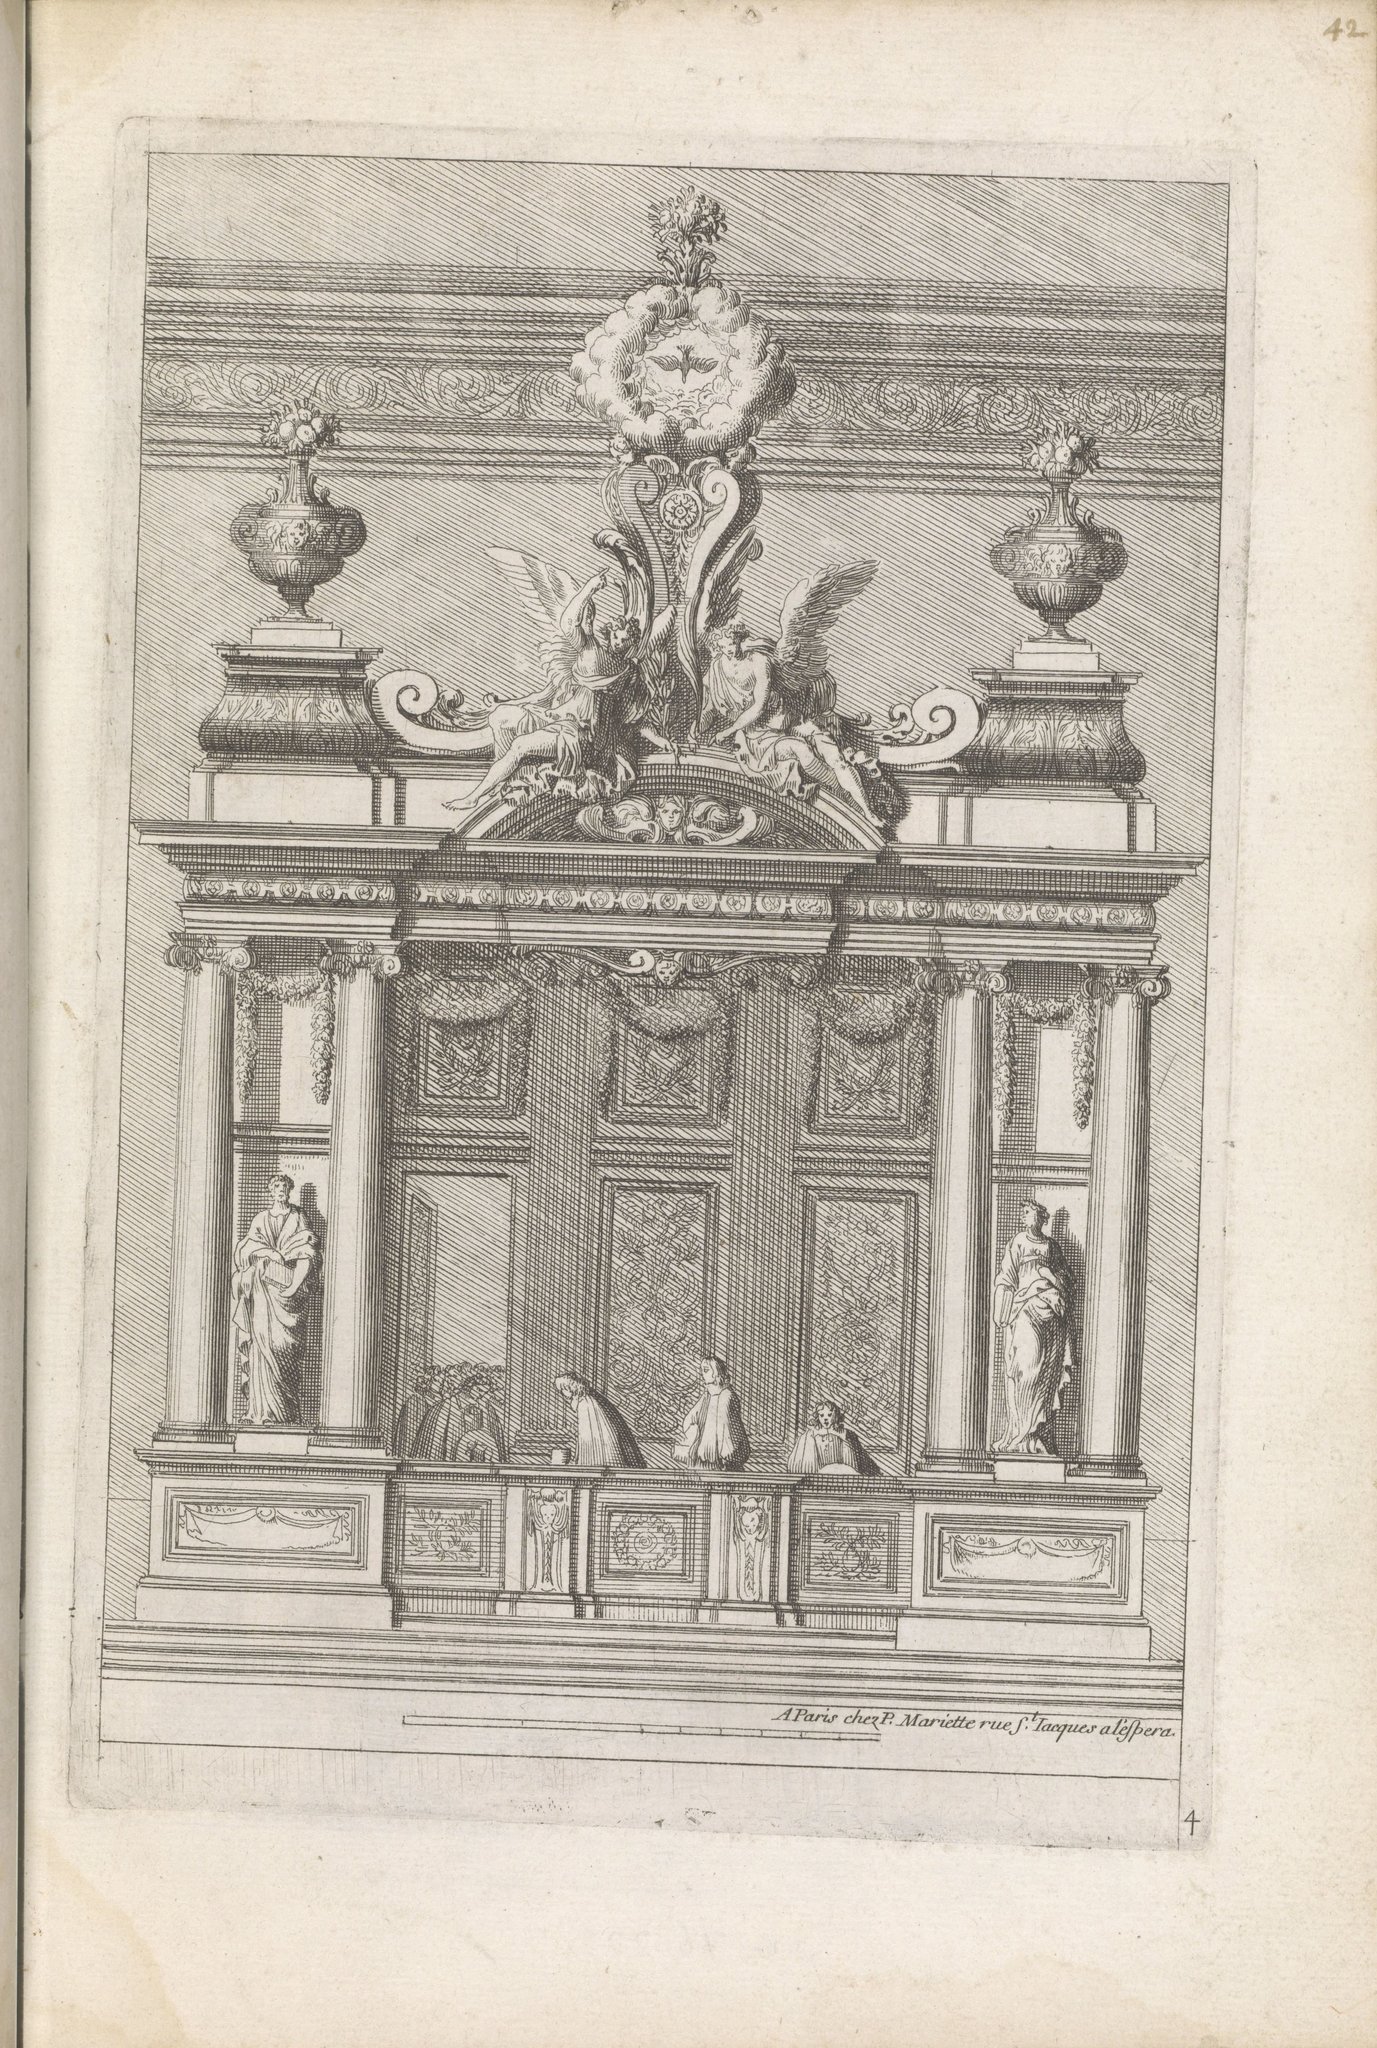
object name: album leaf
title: Koorbank met aan weerszijden Ionische zuilen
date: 1657-1665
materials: paper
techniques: etching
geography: paris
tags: ornaments ~ art, seats of the clergy, choir-stalls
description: Koorbank met aan weerszijden Ionische zuilen. Prent maakt deel uit van een album.